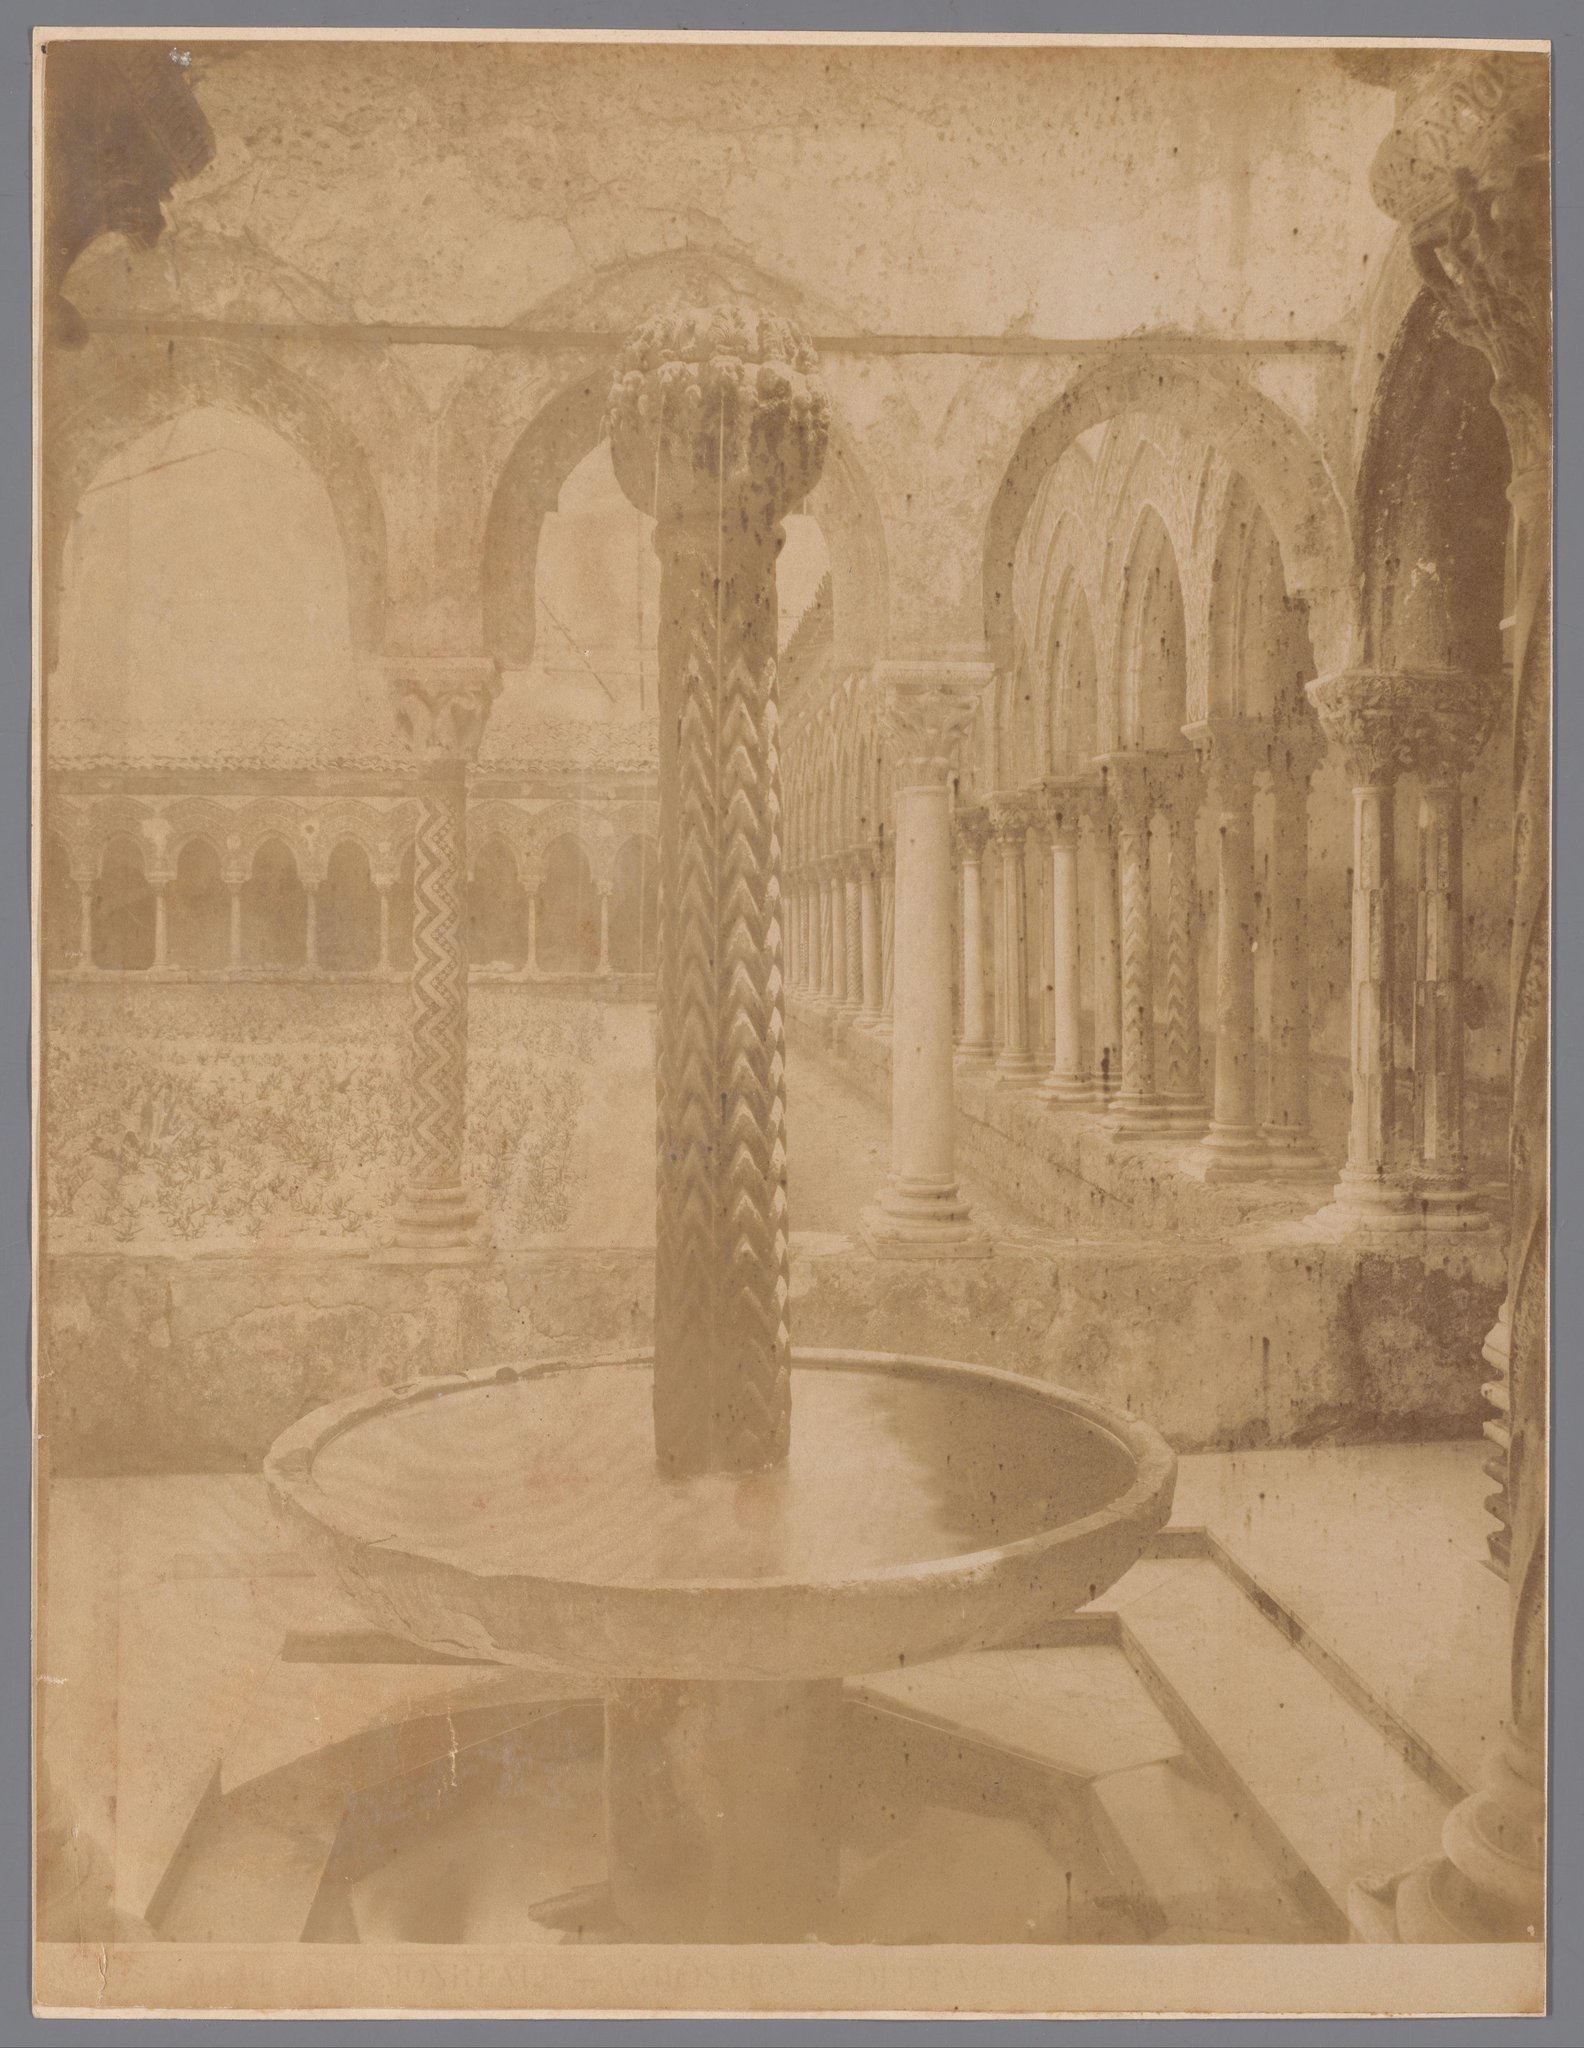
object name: photograph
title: Monreale, Chiostro, dettaglio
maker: giuseppe incorpora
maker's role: fotograaf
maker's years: 1834-1914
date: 1856-1914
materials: cardboard, paper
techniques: albumen print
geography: monreale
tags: abbey, monastery, convent ~ roman catholic church